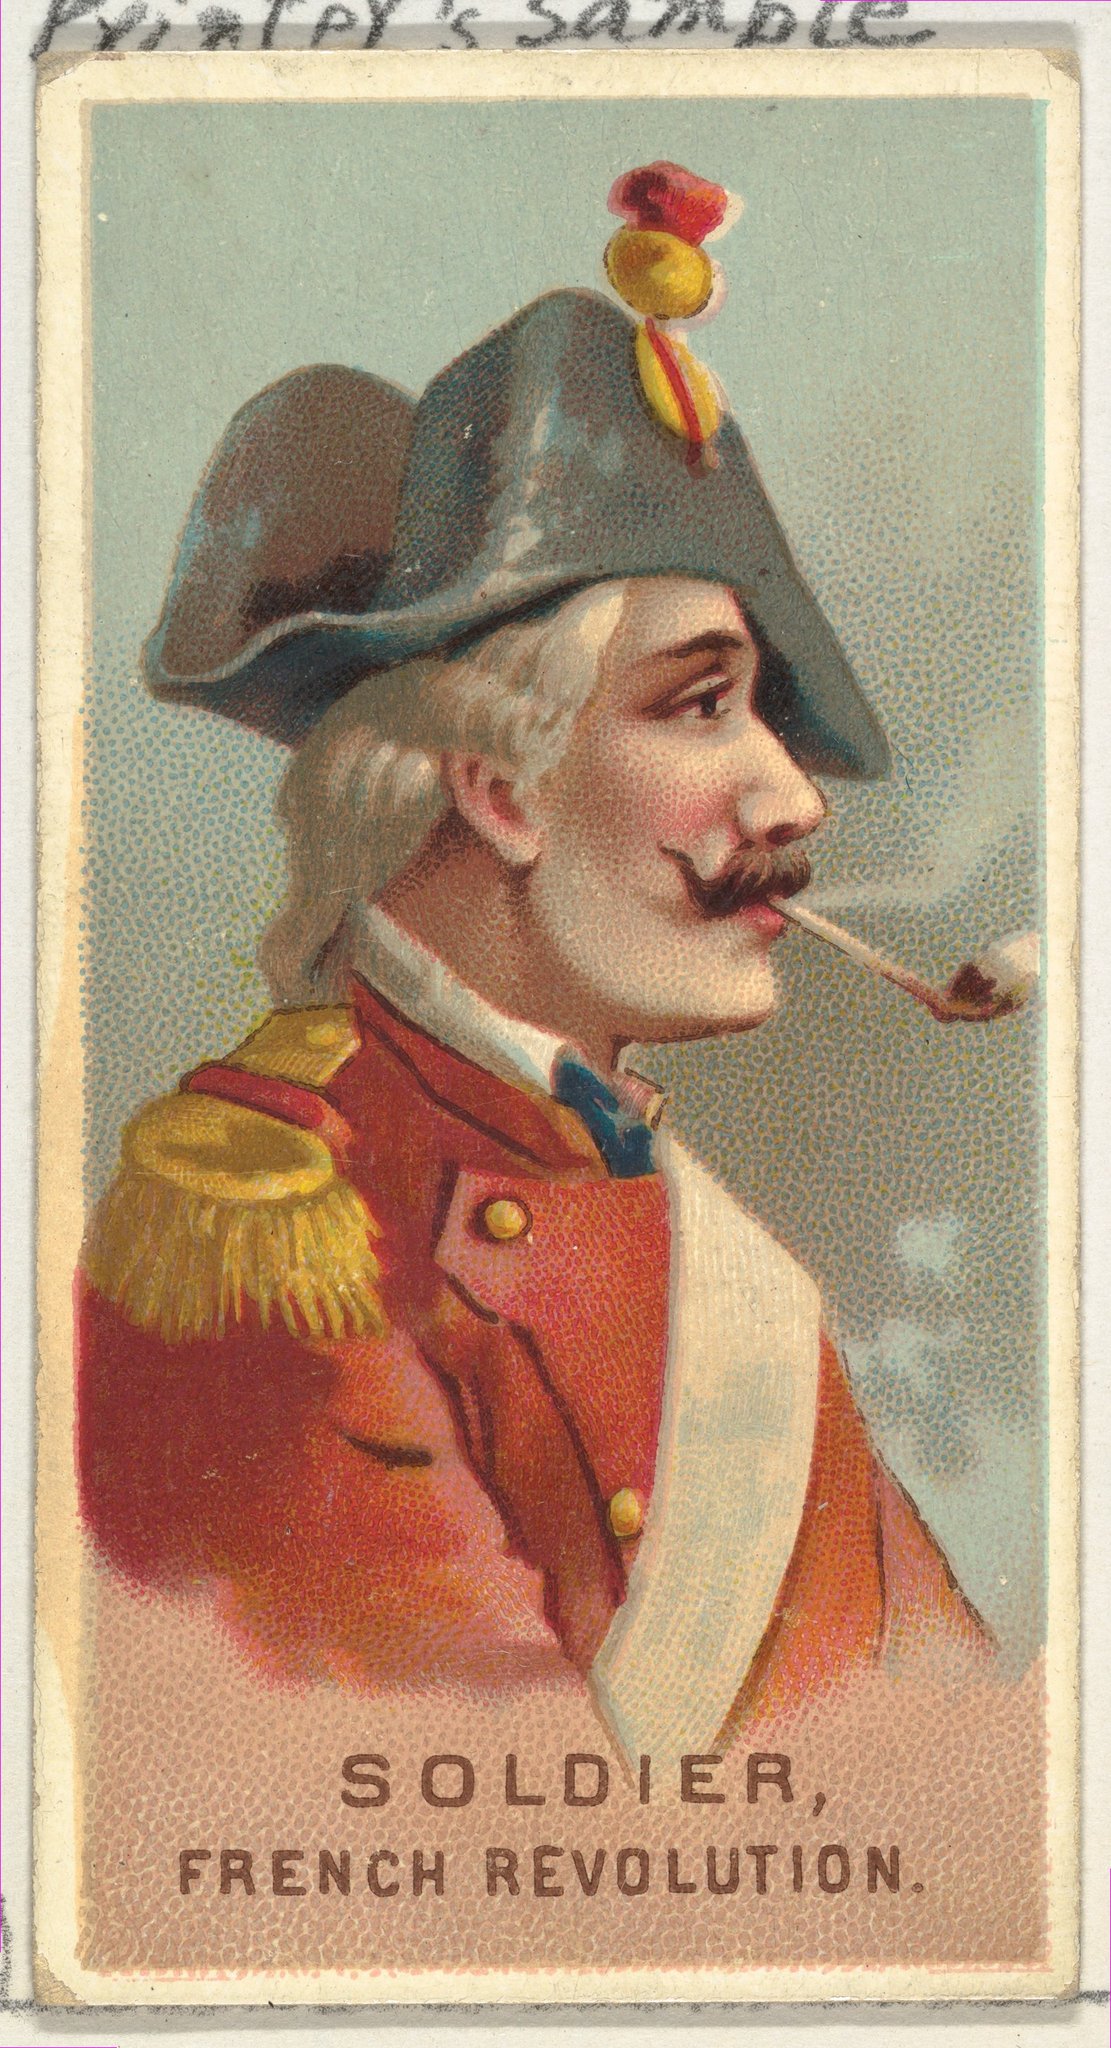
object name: print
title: Soldier, French Revolution, from World's Smokers series (N33) for Allen & Ginter Cigarettes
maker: allen & ginter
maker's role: publisher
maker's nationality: american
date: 1888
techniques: color lithograph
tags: soldiers,french revolution,men,profiles,smoking